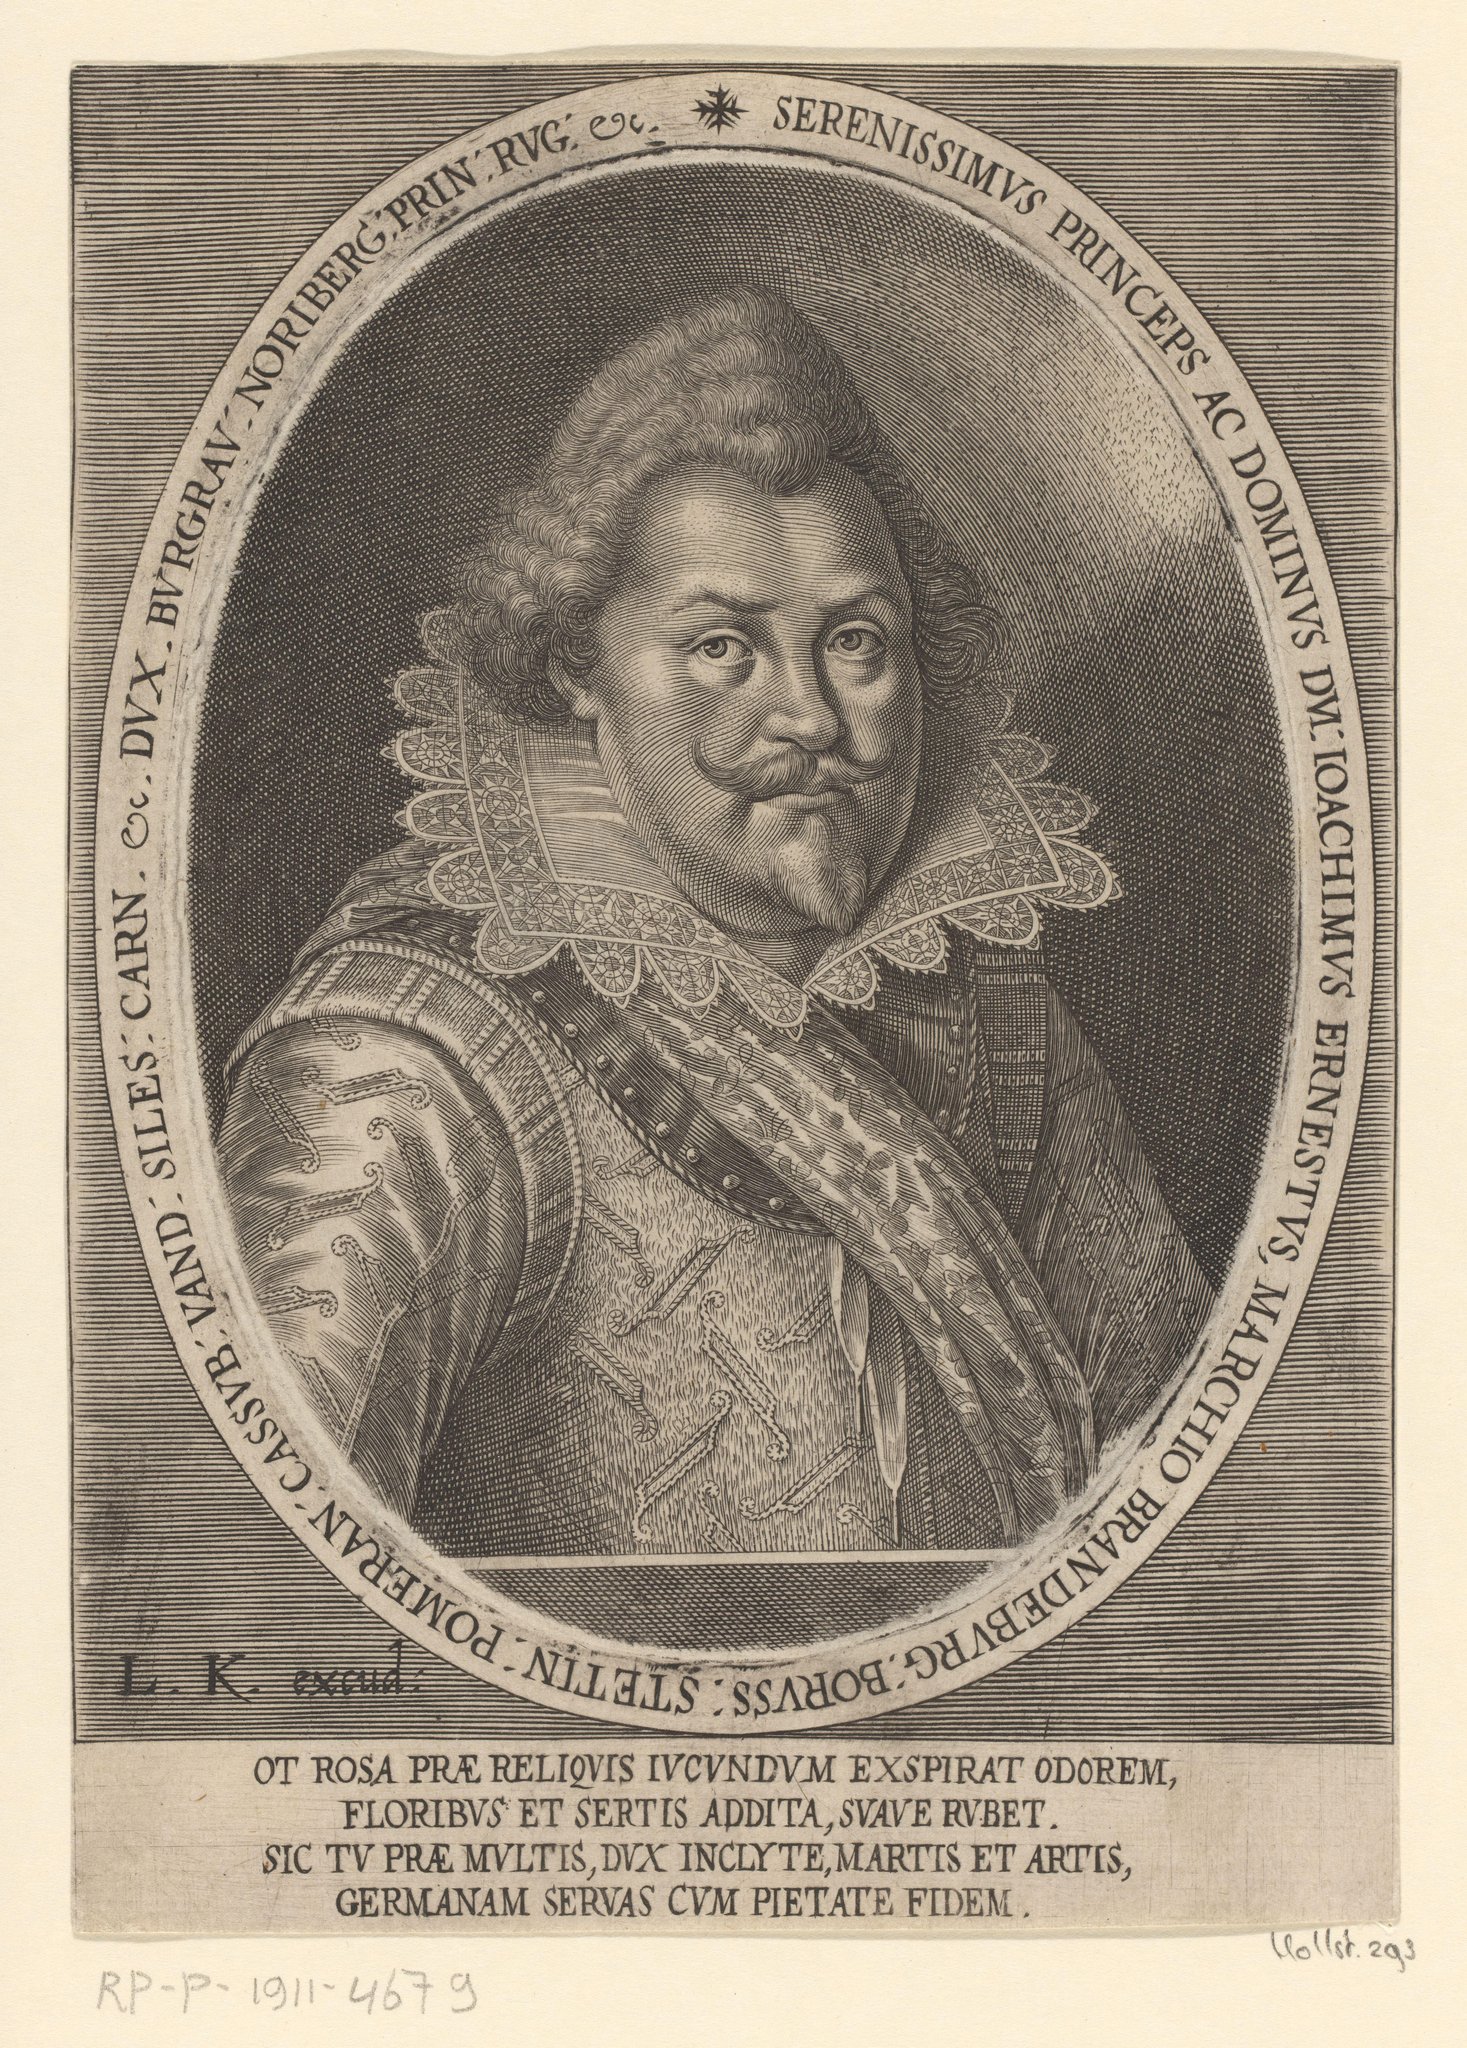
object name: print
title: Portret van Joachim Ernst von Brandenburg-Ansbach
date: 1603-1637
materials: paper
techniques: engraving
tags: joachim ernst von brandenburg-ansbach, historical persons, ambassador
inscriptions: collector's mark: Lugt 2228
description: Tekst in het Latijn in de omlijsting en in de ondermarge.